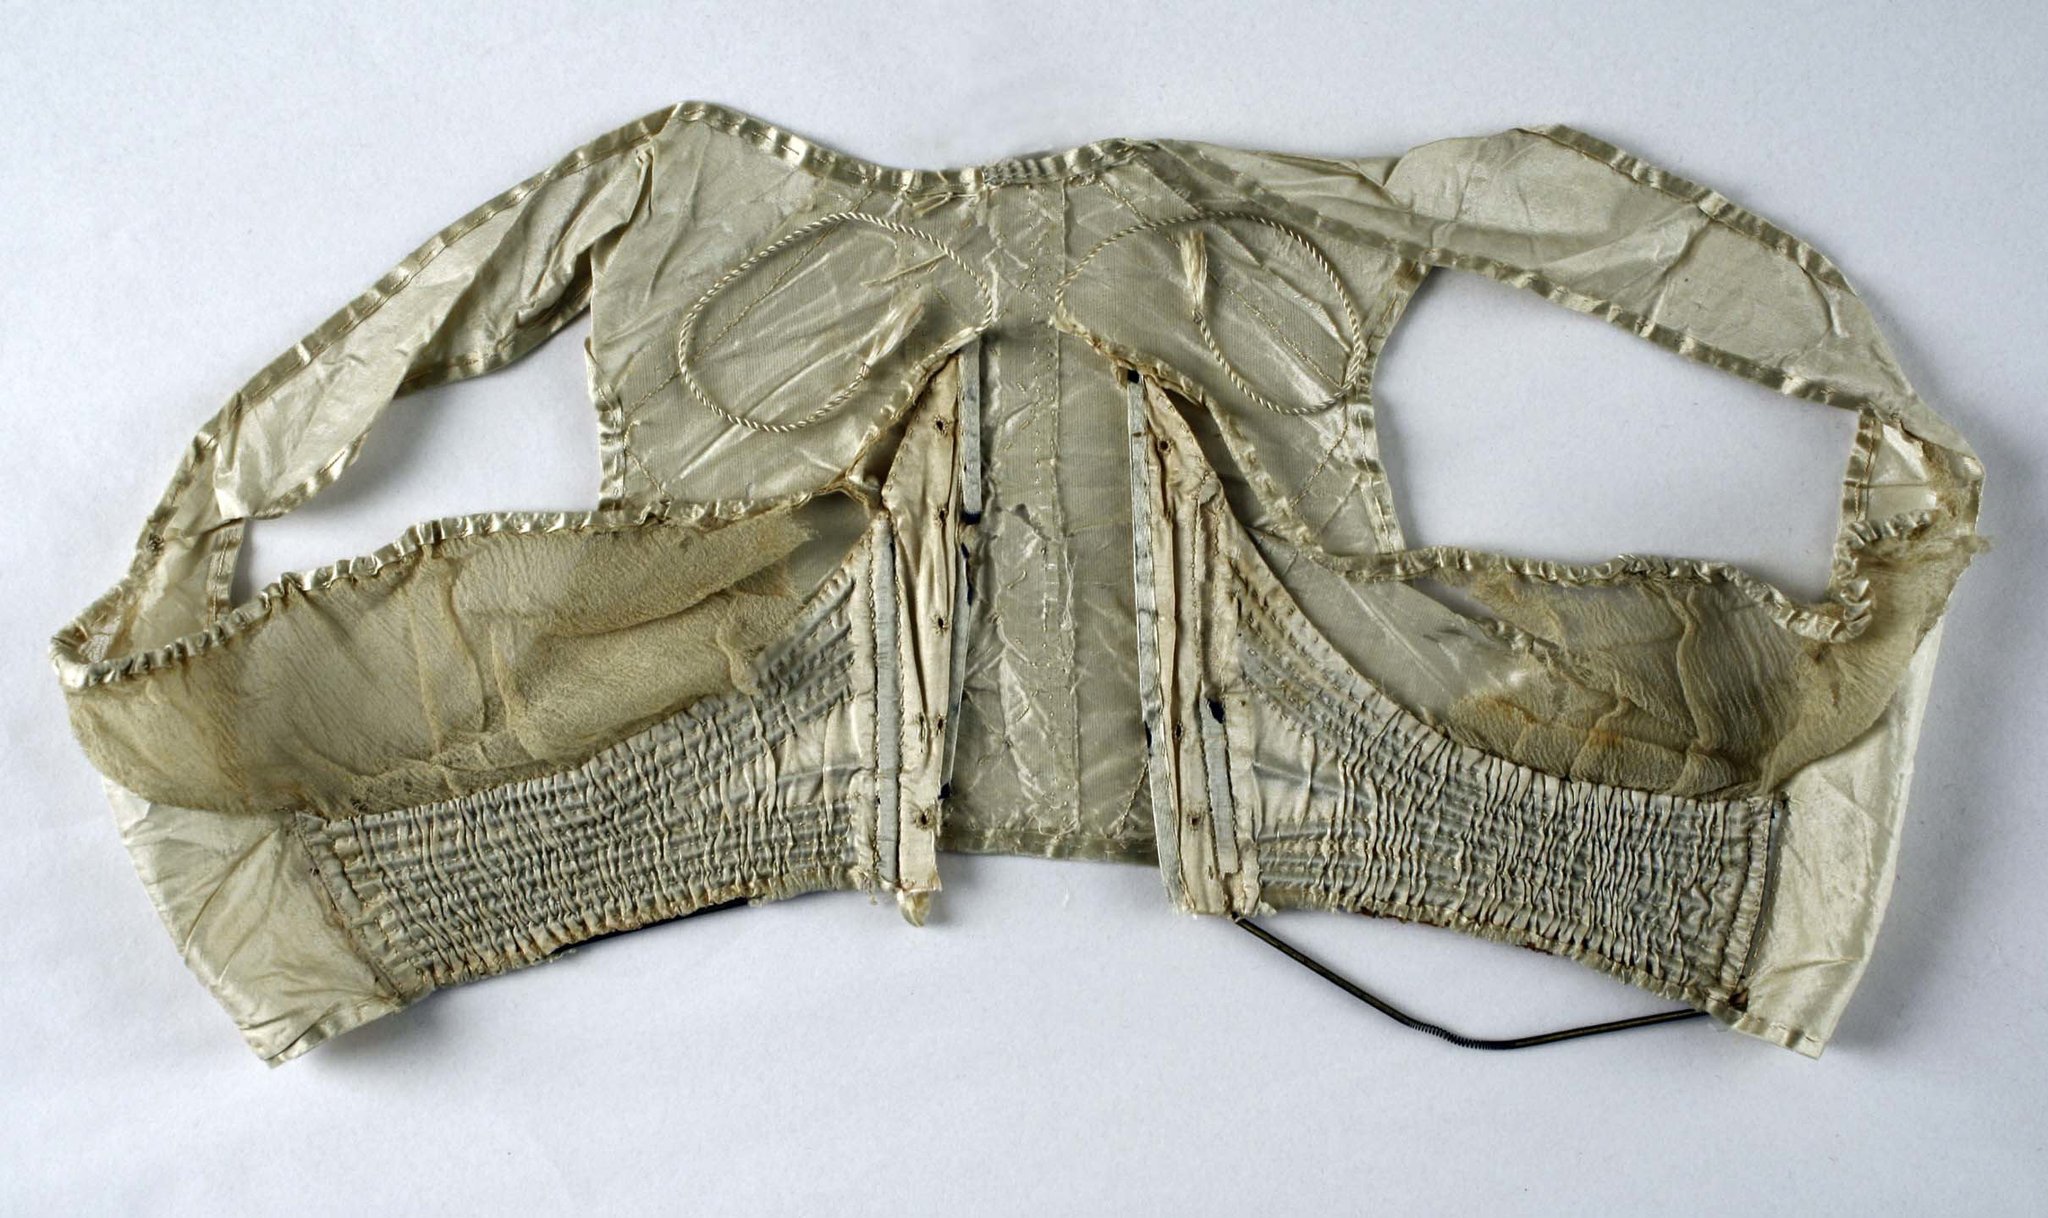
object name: corset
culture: french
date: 1805-1810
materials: metal, silk